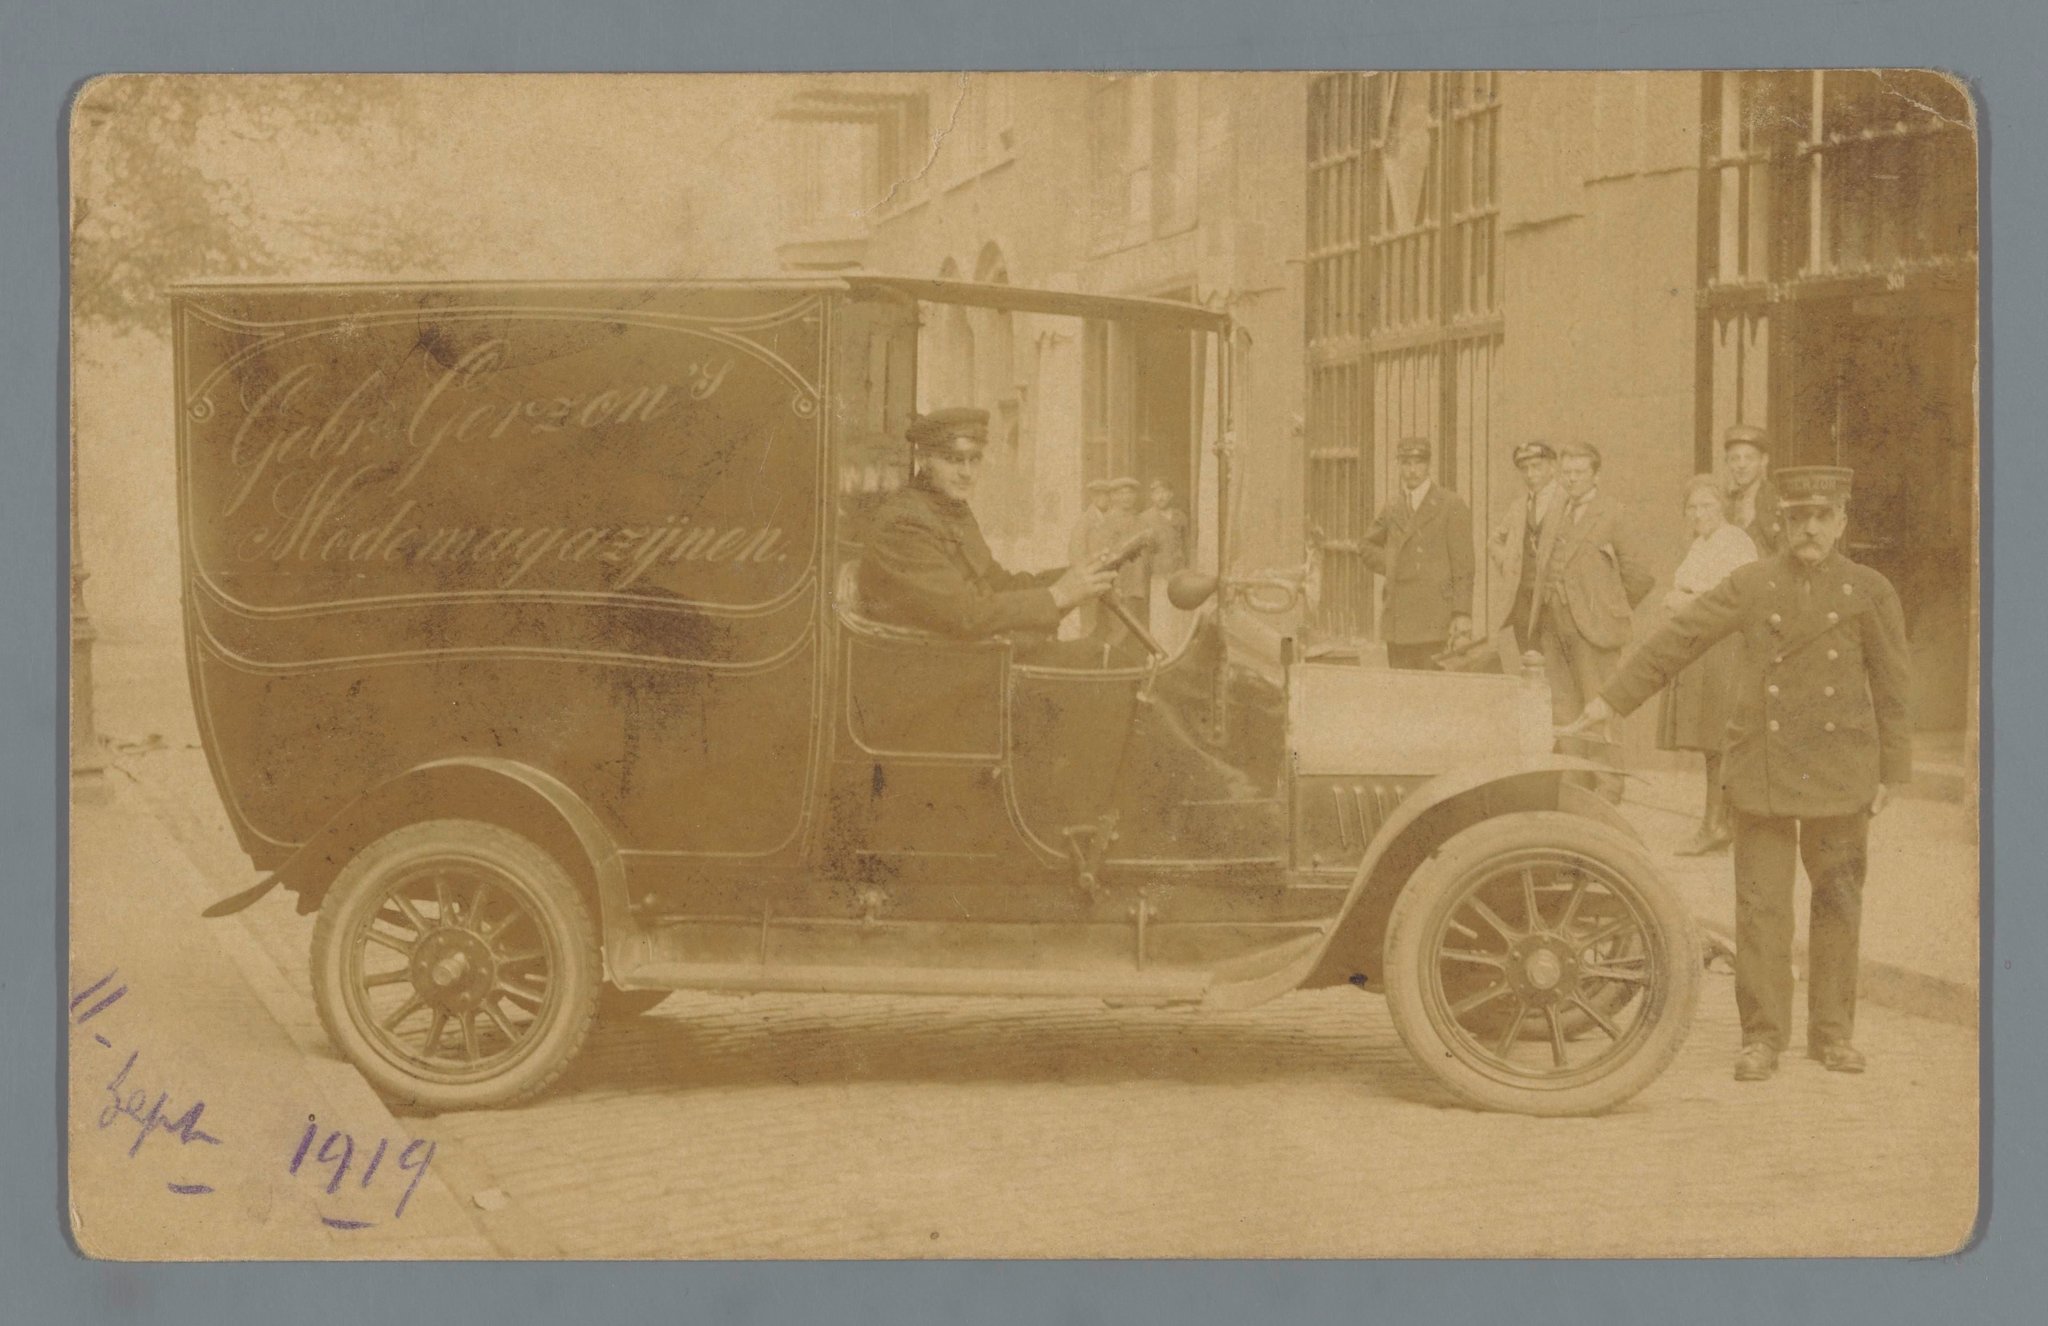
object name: photograph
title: Auto van Gebroeders Gerzon's Modemagazijnen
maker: Anonymous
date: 1919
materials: photographic support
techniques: gelatin silver print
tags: adult man, automobile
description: De auto staat geparkeerd voor de achterzijde van Gerzon's Modemagazijnen, Nieuwezijds Voorburgwal 305-307 te Amsterdam.